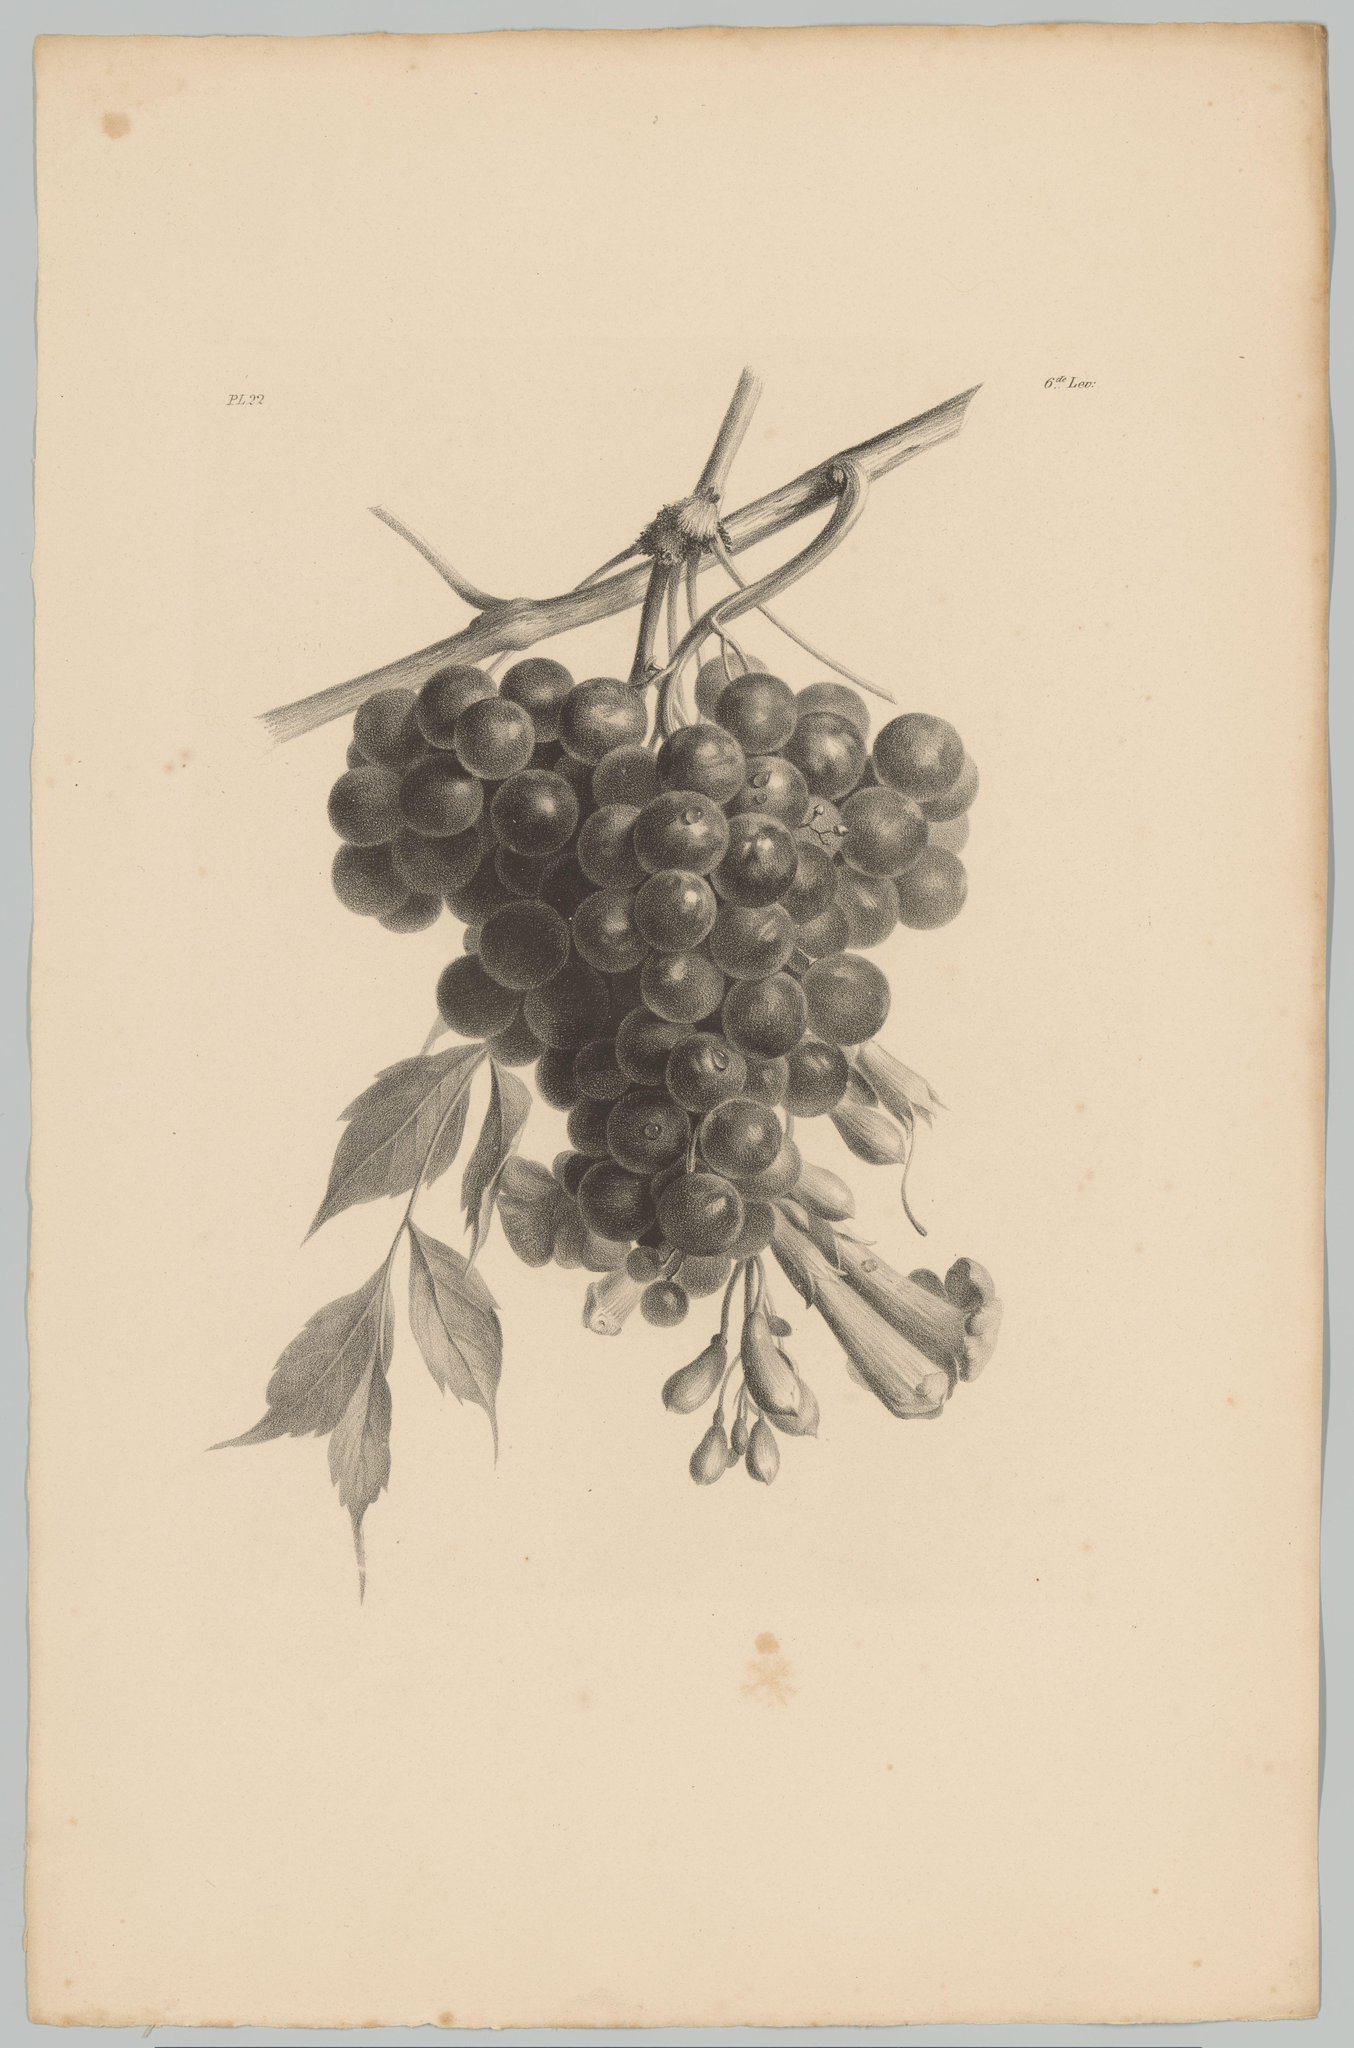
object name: print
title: Druiventros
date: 1820-1833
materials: paper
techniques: lithograph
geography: amsterdam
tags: bunch of grapes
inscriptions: collector's mark: Lugt 2228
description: Rechts boven genummerd 5de Lev. Onderdeel van een omslag met in totaal zevenenzeventig lithografieën van bloemen en fruit.